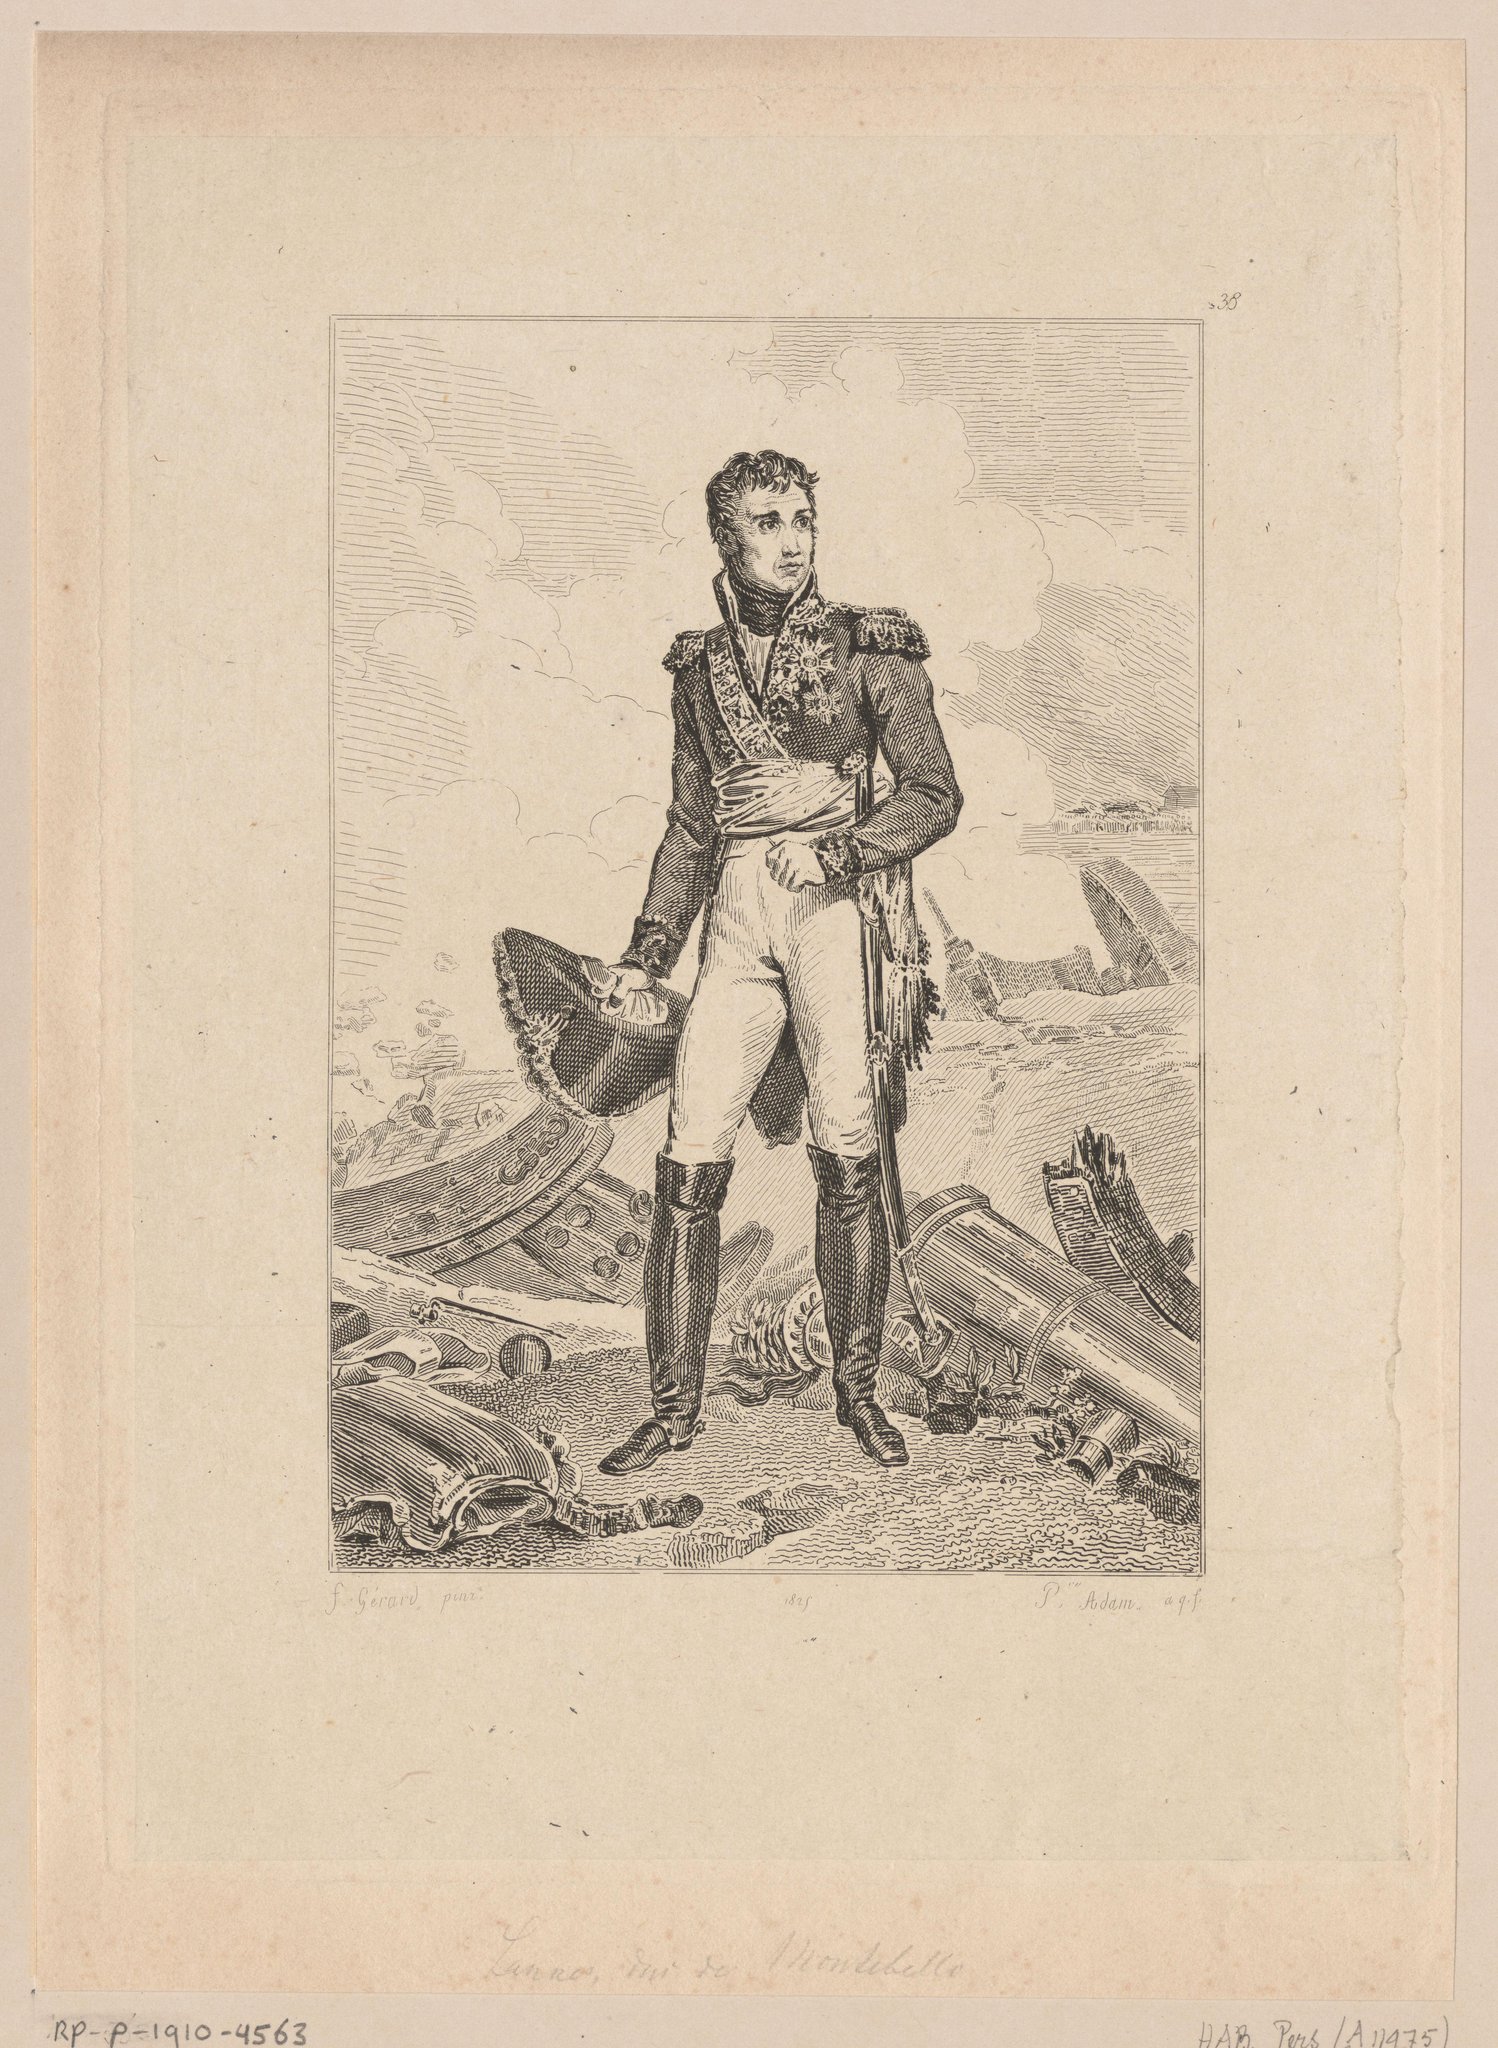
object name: print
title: Collection des Portraits historiques de Mr. le Baron Gérard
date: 1825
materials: paper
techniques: etching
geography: france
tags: commander-in-chief, general, marshal, historical persons, (military) uniforms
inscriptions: collector's mark: Lugt 2228